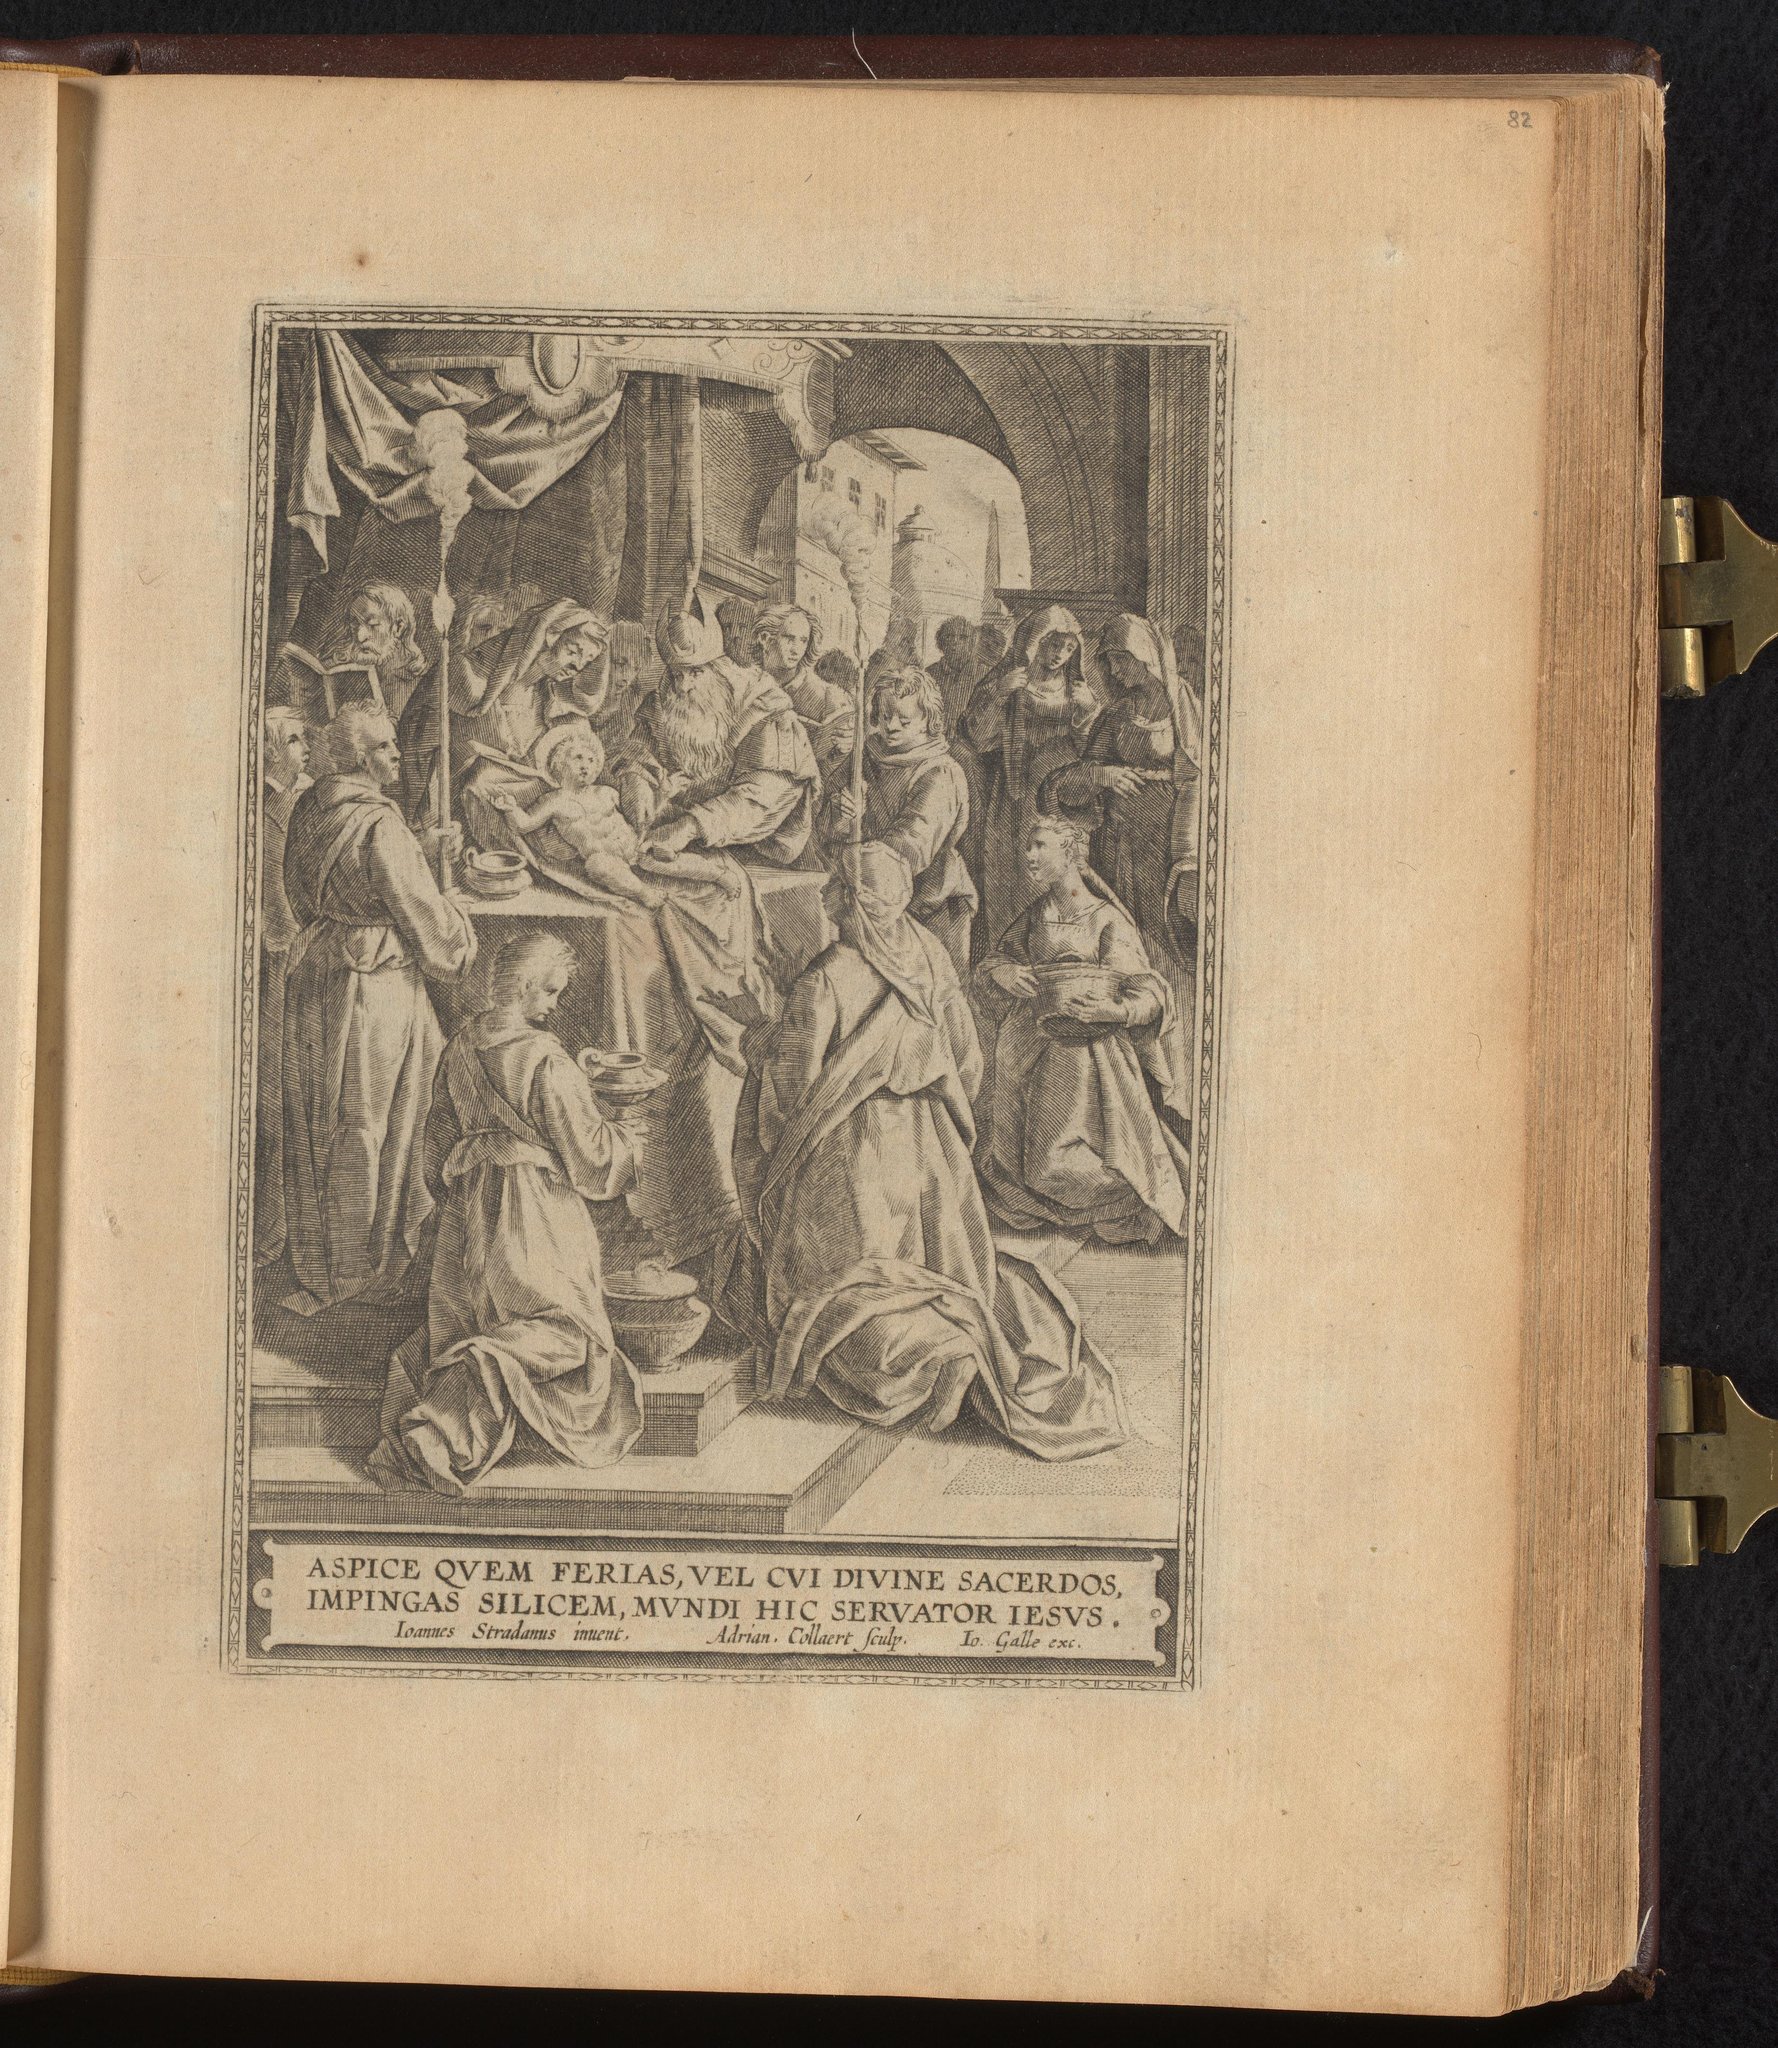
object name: album leaf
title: Besnijdenis van Christus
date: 1589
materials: paper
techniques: engraving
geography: antwerp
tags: circumcision of the christ-child by the priest in the temple (luke 2:21)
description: Prent maakt deel uit van een prentbijbel.